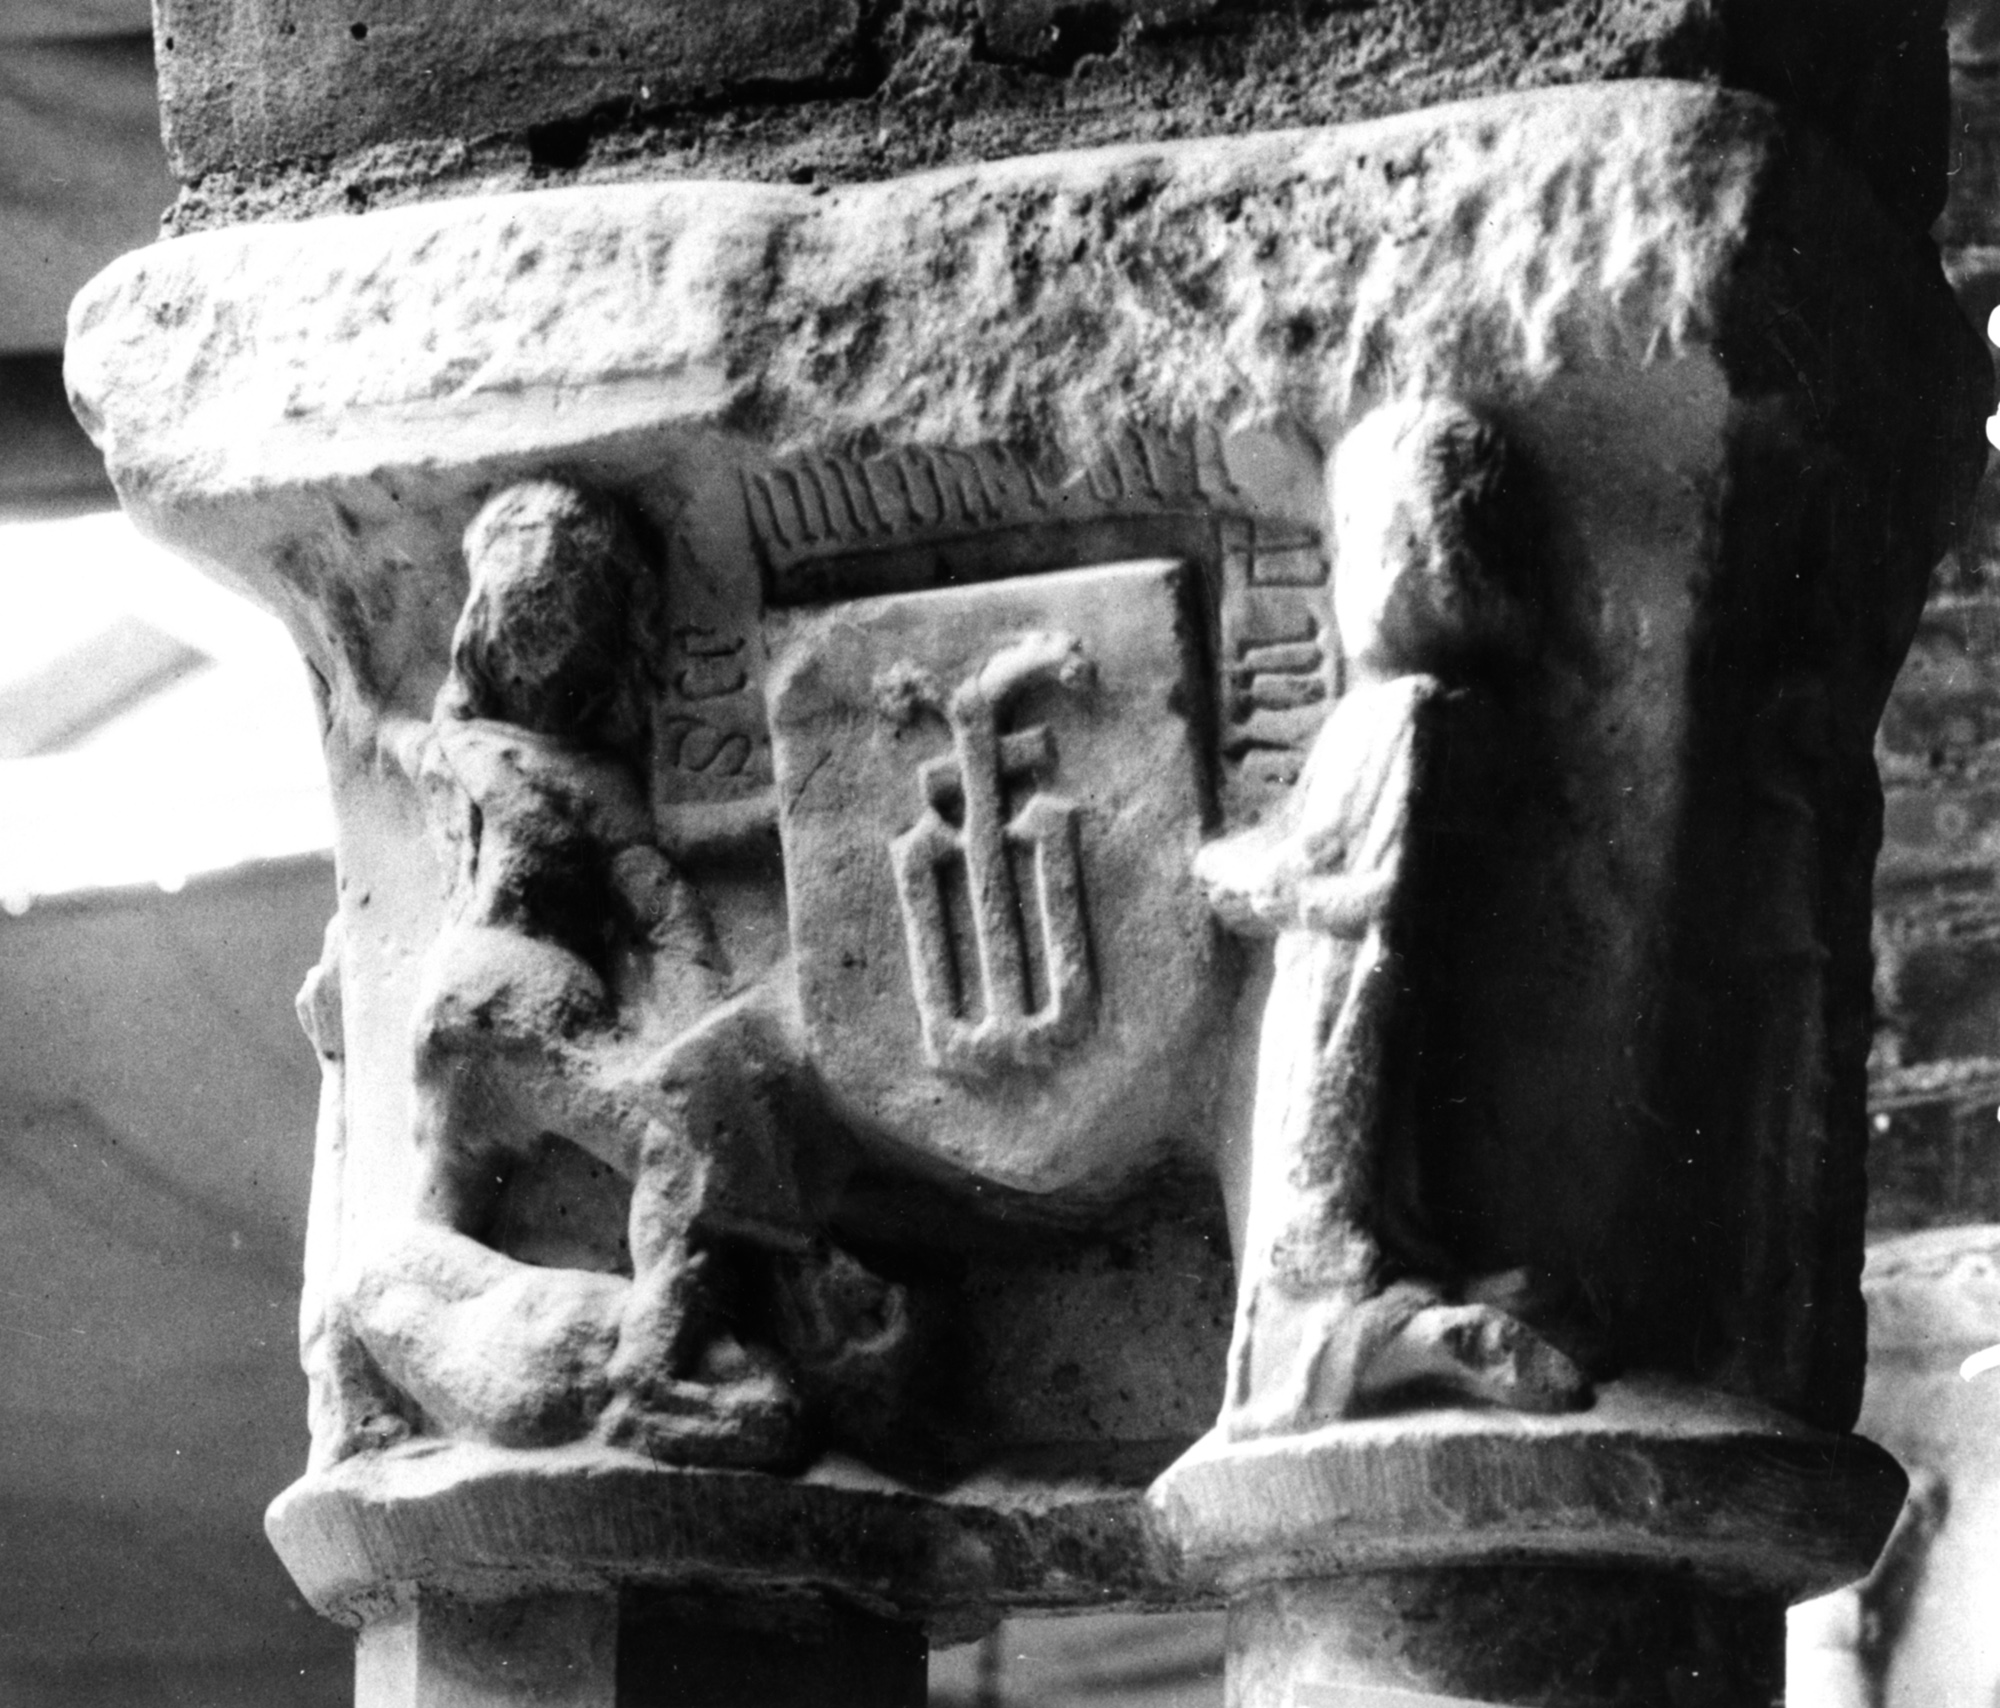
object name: capital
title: Double Capital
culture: french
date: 1467-1500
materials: marble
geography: france